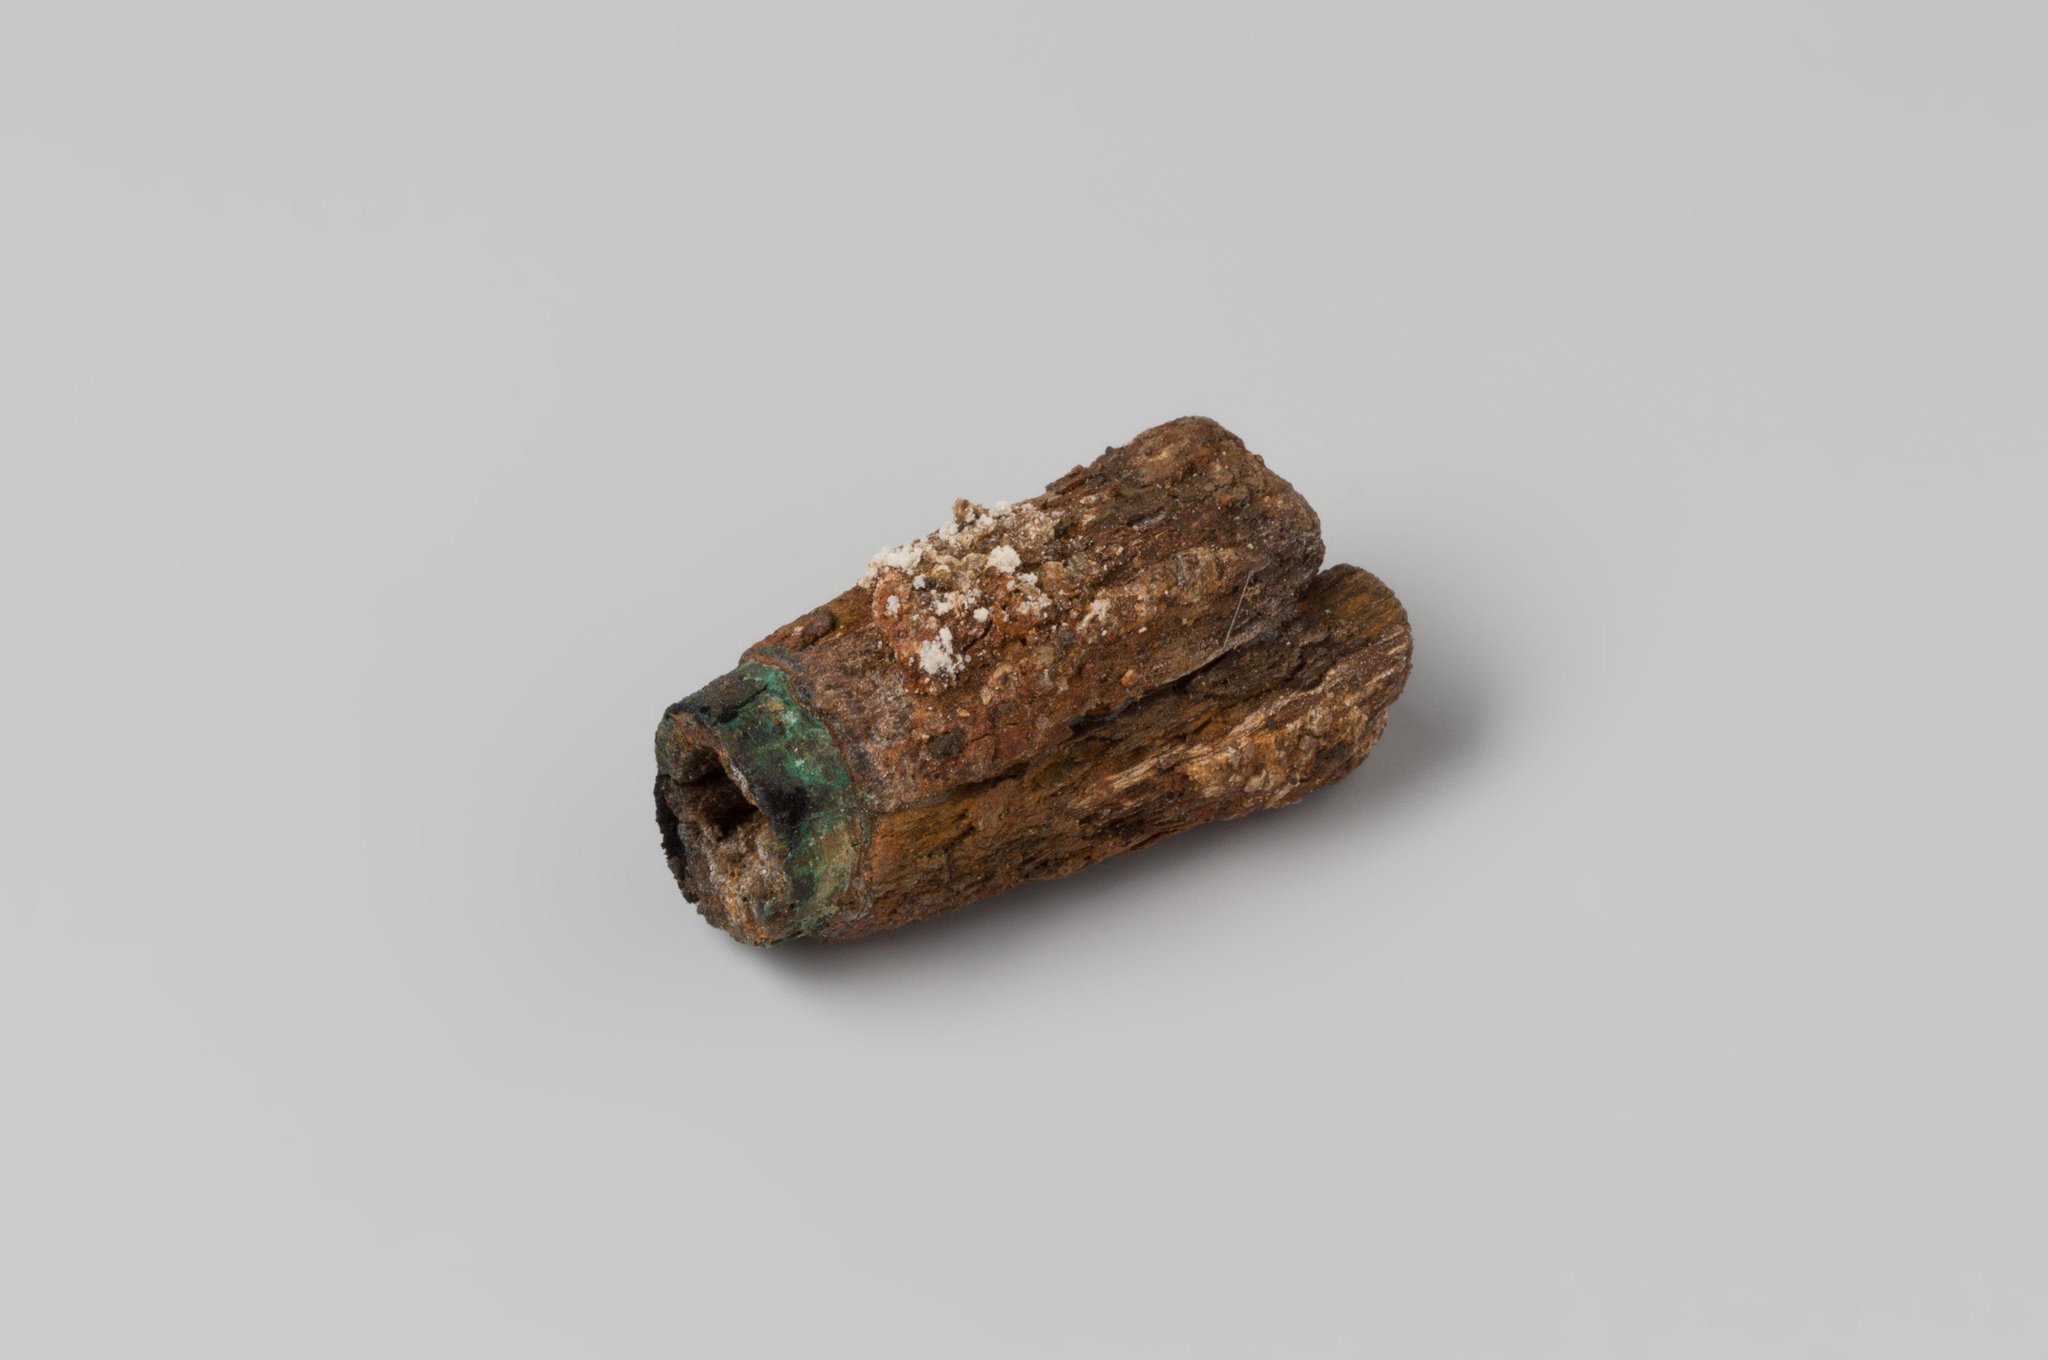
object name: fragment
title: Fragment messenheft uit het wrak van de Oost-Indiëvaarder Hollandia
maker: Anonymous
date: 1700-1743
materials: wood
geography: netherlands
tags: verenigde oostindische compagnie, hollandia (schip), annet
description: Knife, handle, cylindrical: tapering; fragm, id. NG 1979-403H, ferrule, id. NG 1980-27H426.